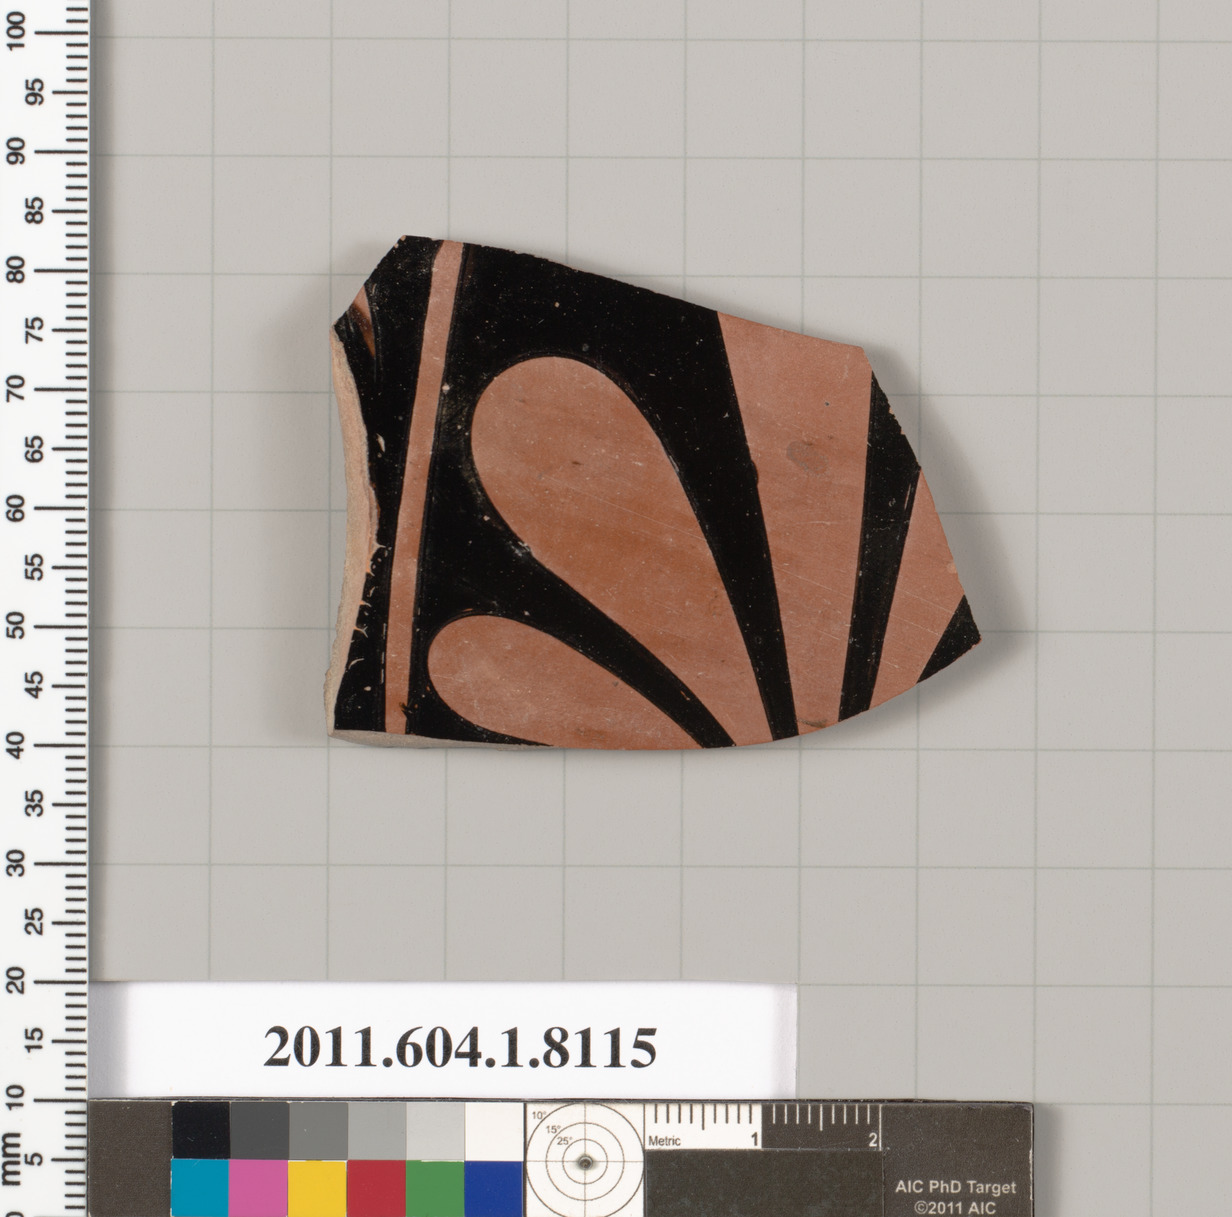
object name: kylix fragment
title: Terracotta fragment of a kylix (drinking cup)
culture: greek, attic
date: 534-468 BCE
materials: terracotta